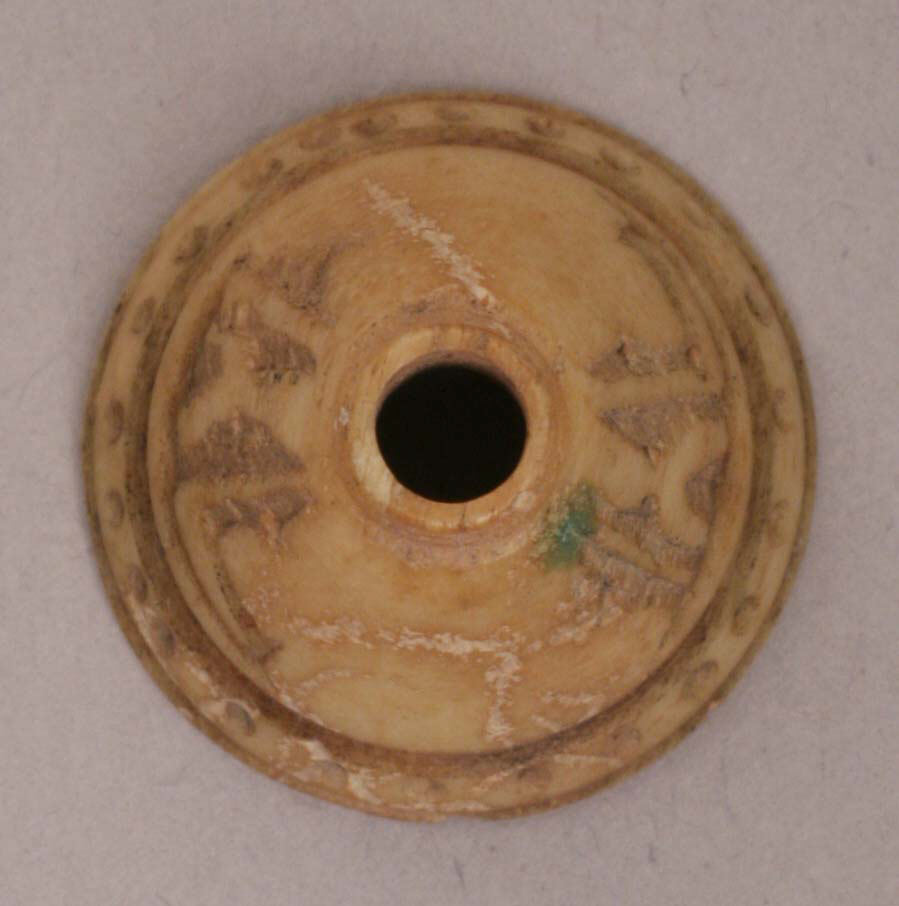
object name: spindle whorl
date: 801-1000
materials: bone, paint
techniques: incising, inlay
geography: iran